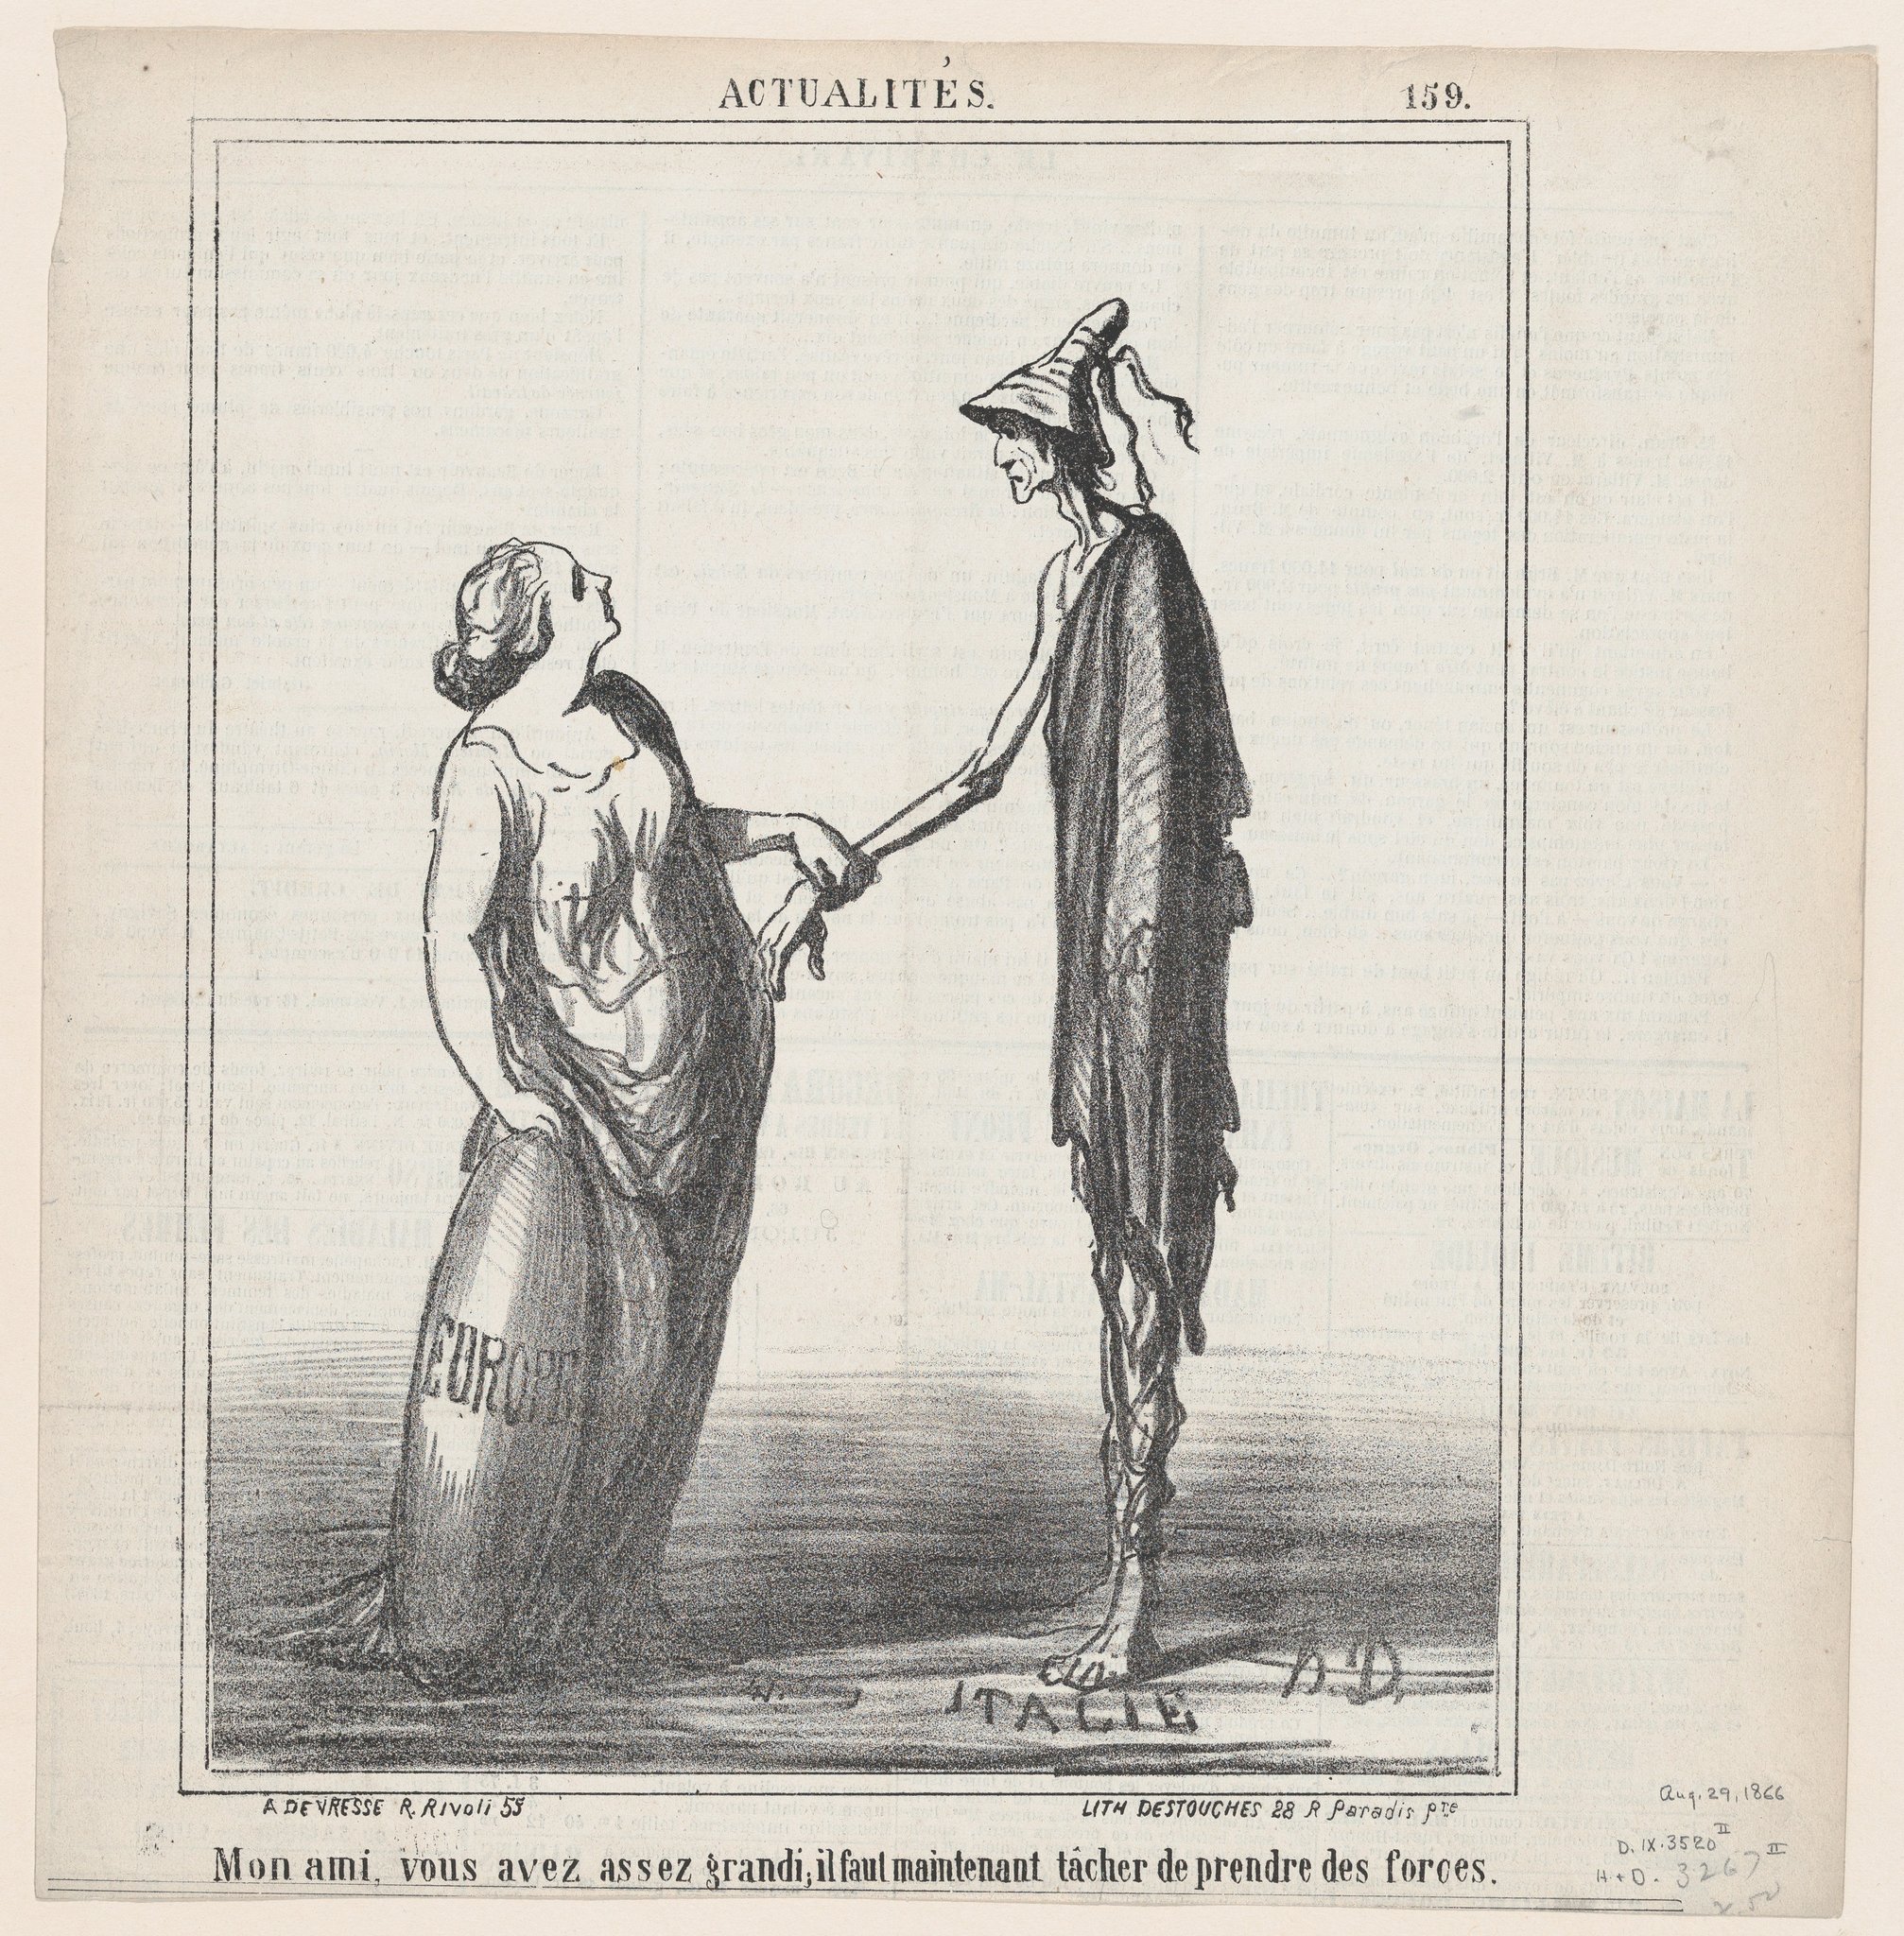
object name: print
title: My friend, you are tall enough; but now you must try to put on some weight!, from "News of the Day"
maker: honoré daumier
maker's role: artist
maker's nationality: french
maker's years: 1808-1879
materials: paper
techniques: lithograph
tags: satire,men,women